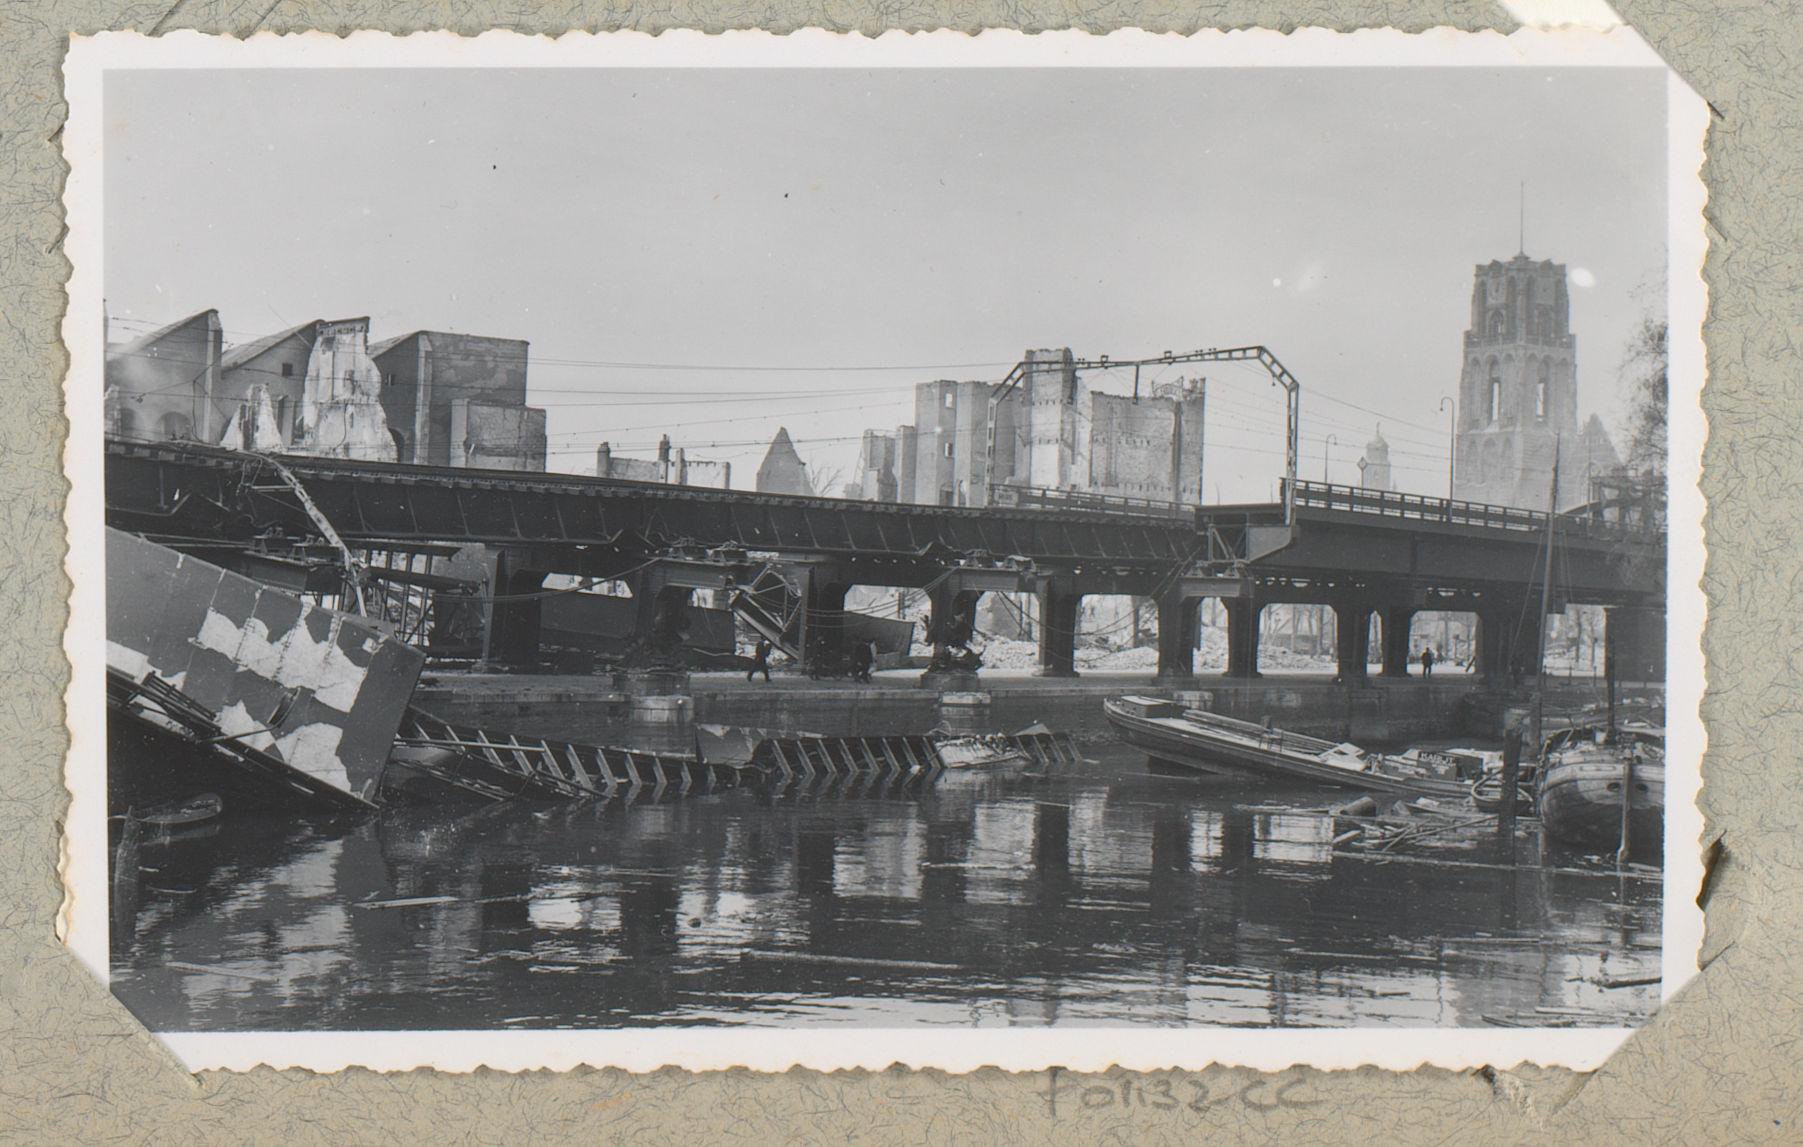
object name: photograph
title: Ruïnes rond de brug bij de Kolk te Rotterdam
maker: j. nolte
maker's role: fotograaf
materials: photographic support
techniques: gelatin silver print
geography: rotterdam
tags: landscapes with waters, waterscapes, seascapes (in the temperate zone), devastated, ruined place or city (~ warfare), bridge, rotterdam, rotterdam blitz